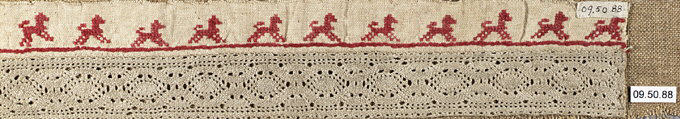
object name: fragment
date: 1801-1900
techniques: lace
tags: animals